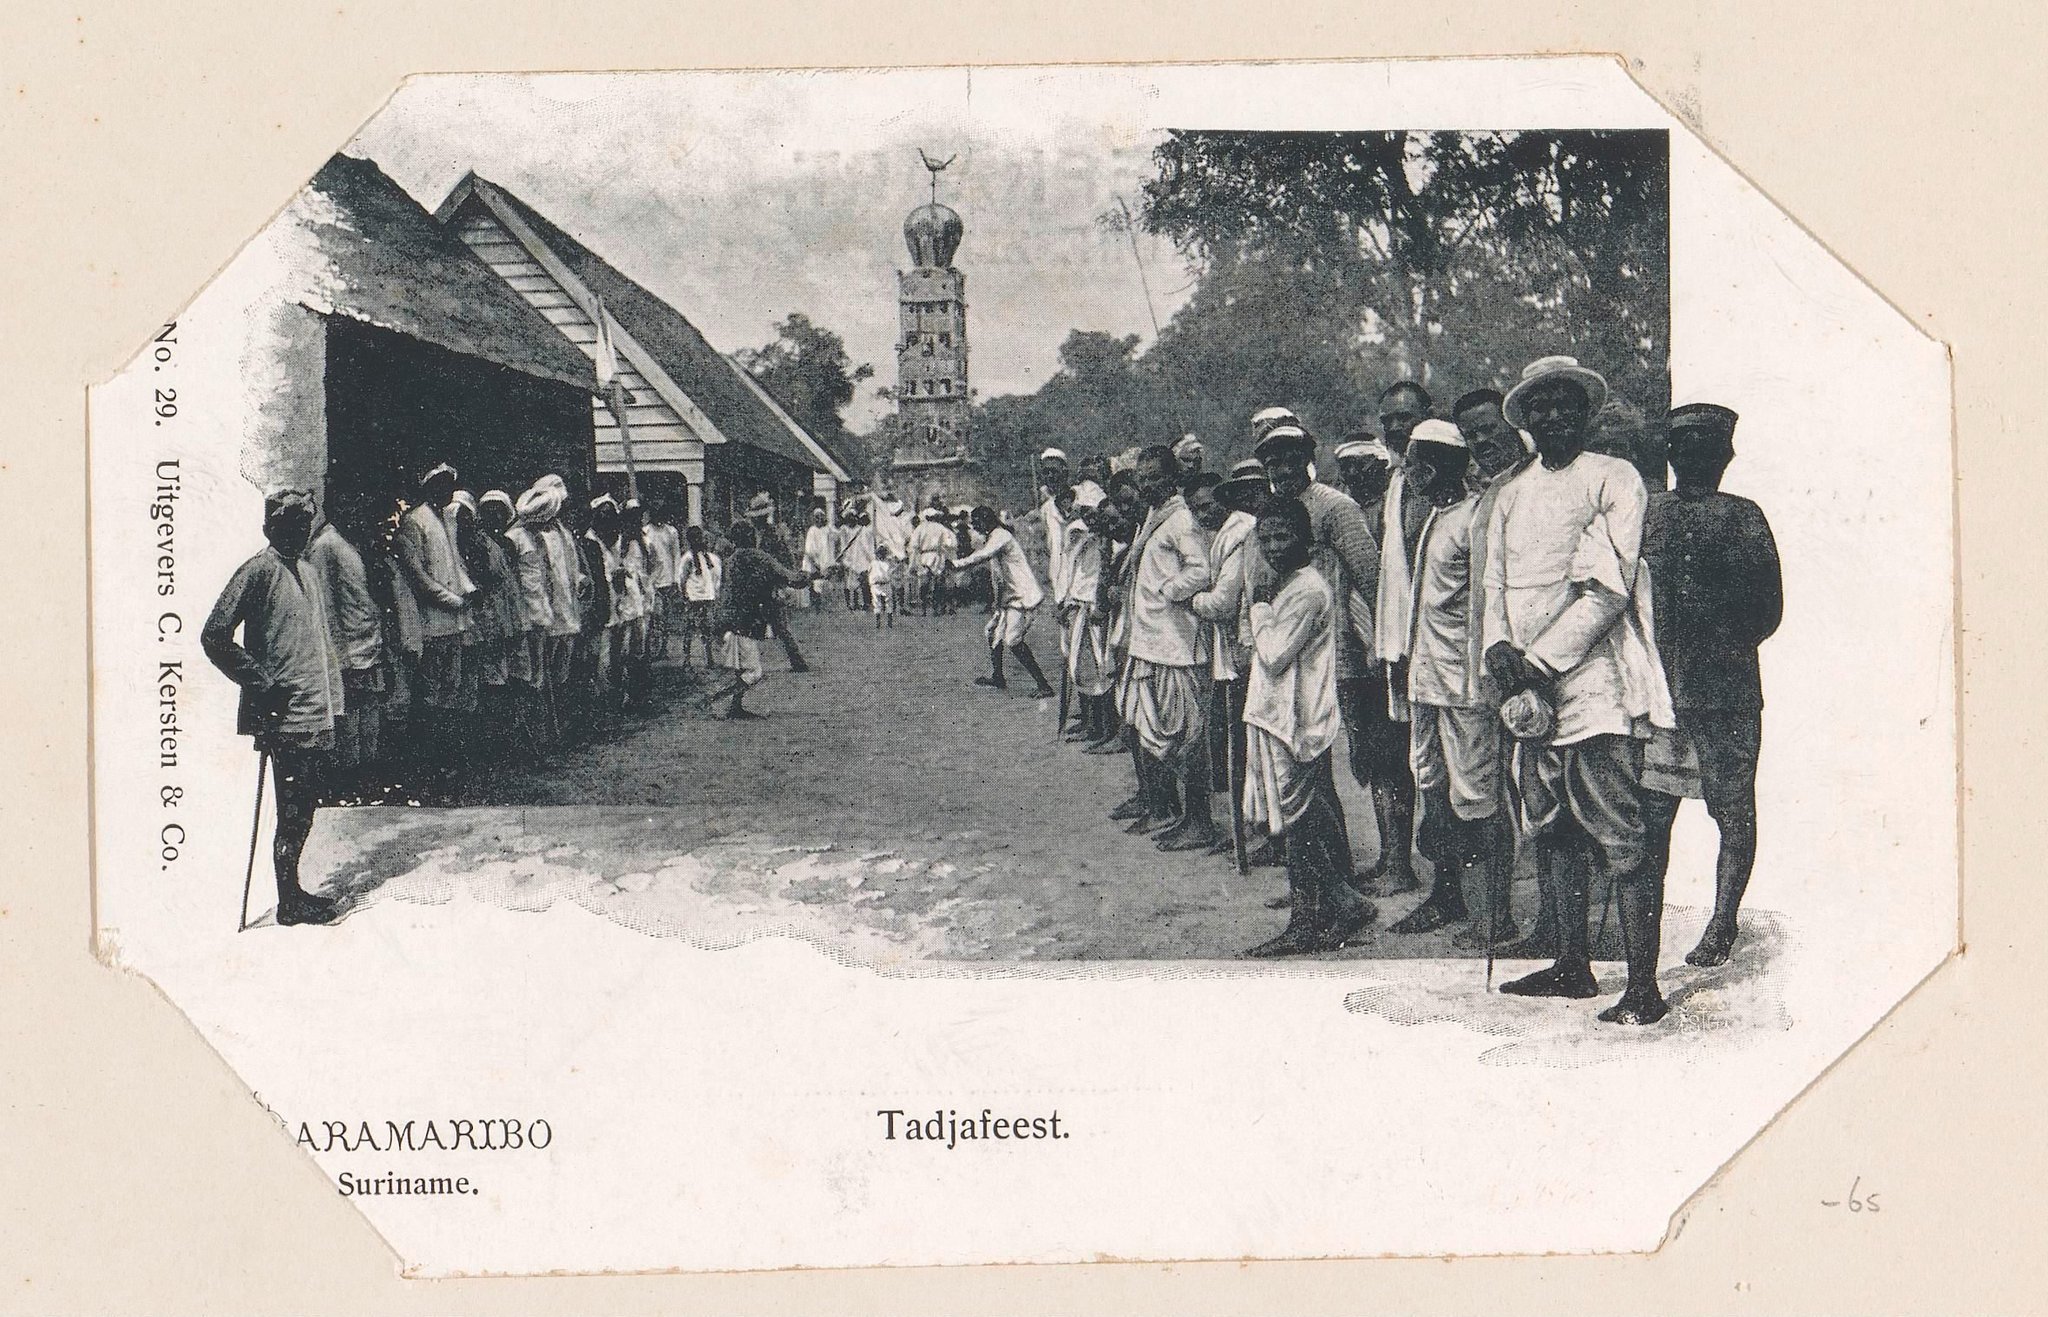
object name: ansichtkaart, prentbriefkaart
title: Tadjafeest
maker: julius muller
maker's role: official, politician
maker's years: 1846-1902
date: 1900-1910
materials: cardboard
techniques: autotype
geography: paramaribo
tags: ritual music and dancing ~ islam, mohammedanism, temple, shrine ~ islam, mohammedanism, suriname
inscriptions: serial number: ‘No. 29. Uitgevers C. Kersten & Co., Paramaribo’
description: De viering van het Tadja feest of tajiya-festival door de moslims onder de Brits-Indische immigranten in Suriname. Onderdeel van een verzameling van 68 briefkaarten uit Suriname, bijeengebracht in een album als aandenken aan een verblijf in Suriname in september 1911.